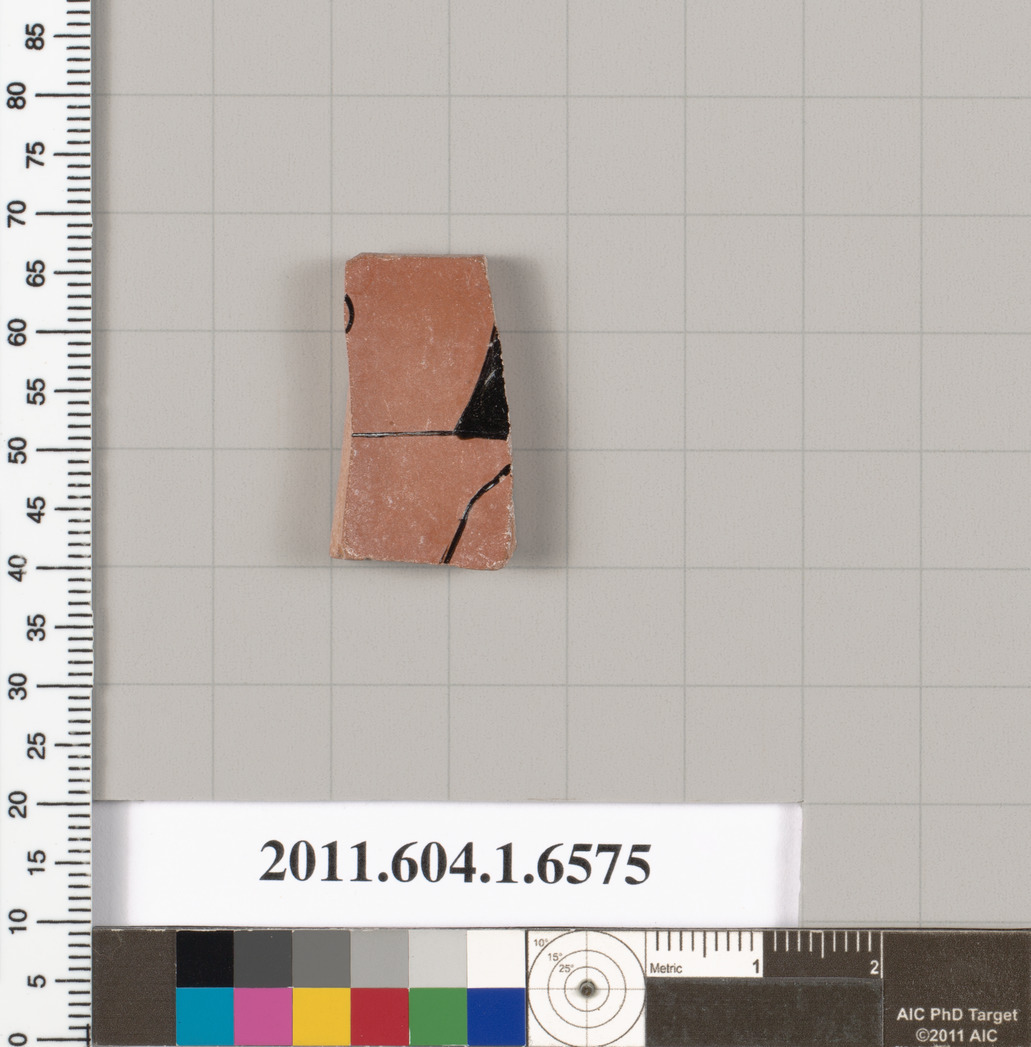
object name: kylix fragment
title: Terracotta fragment of a kylix (drinking cup)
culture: greek, attic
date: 490-480 BCE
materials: terracotta